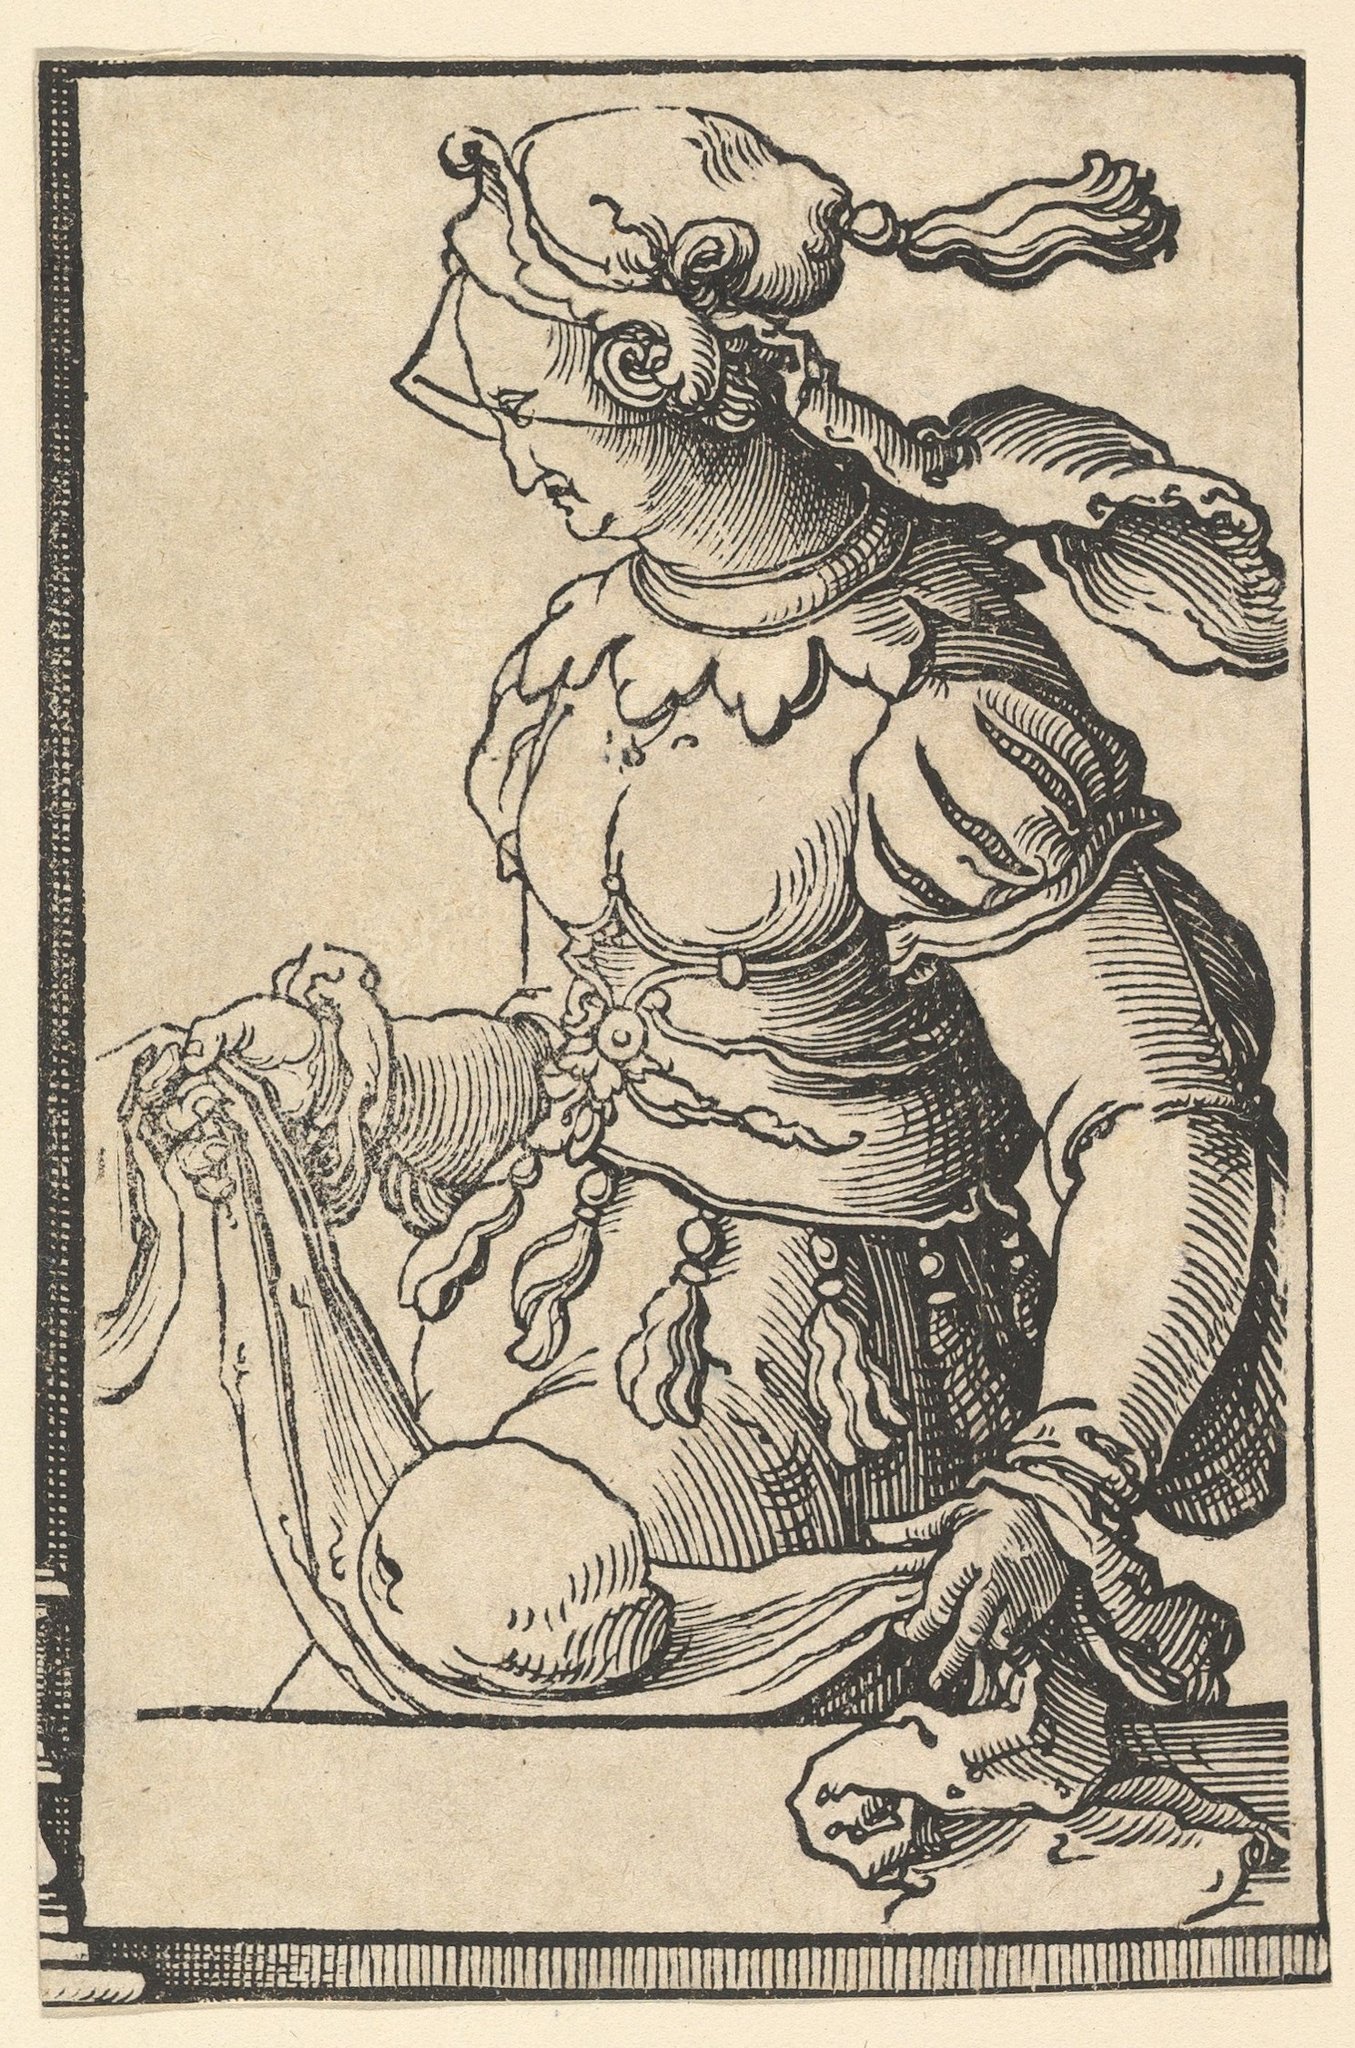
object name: print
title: Cumean Sibyl, from the series of Sibyls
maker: lucas van leyden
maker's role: artist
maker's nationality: netherlandish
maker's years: 1494-1533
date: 1530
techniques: woodcut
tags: women